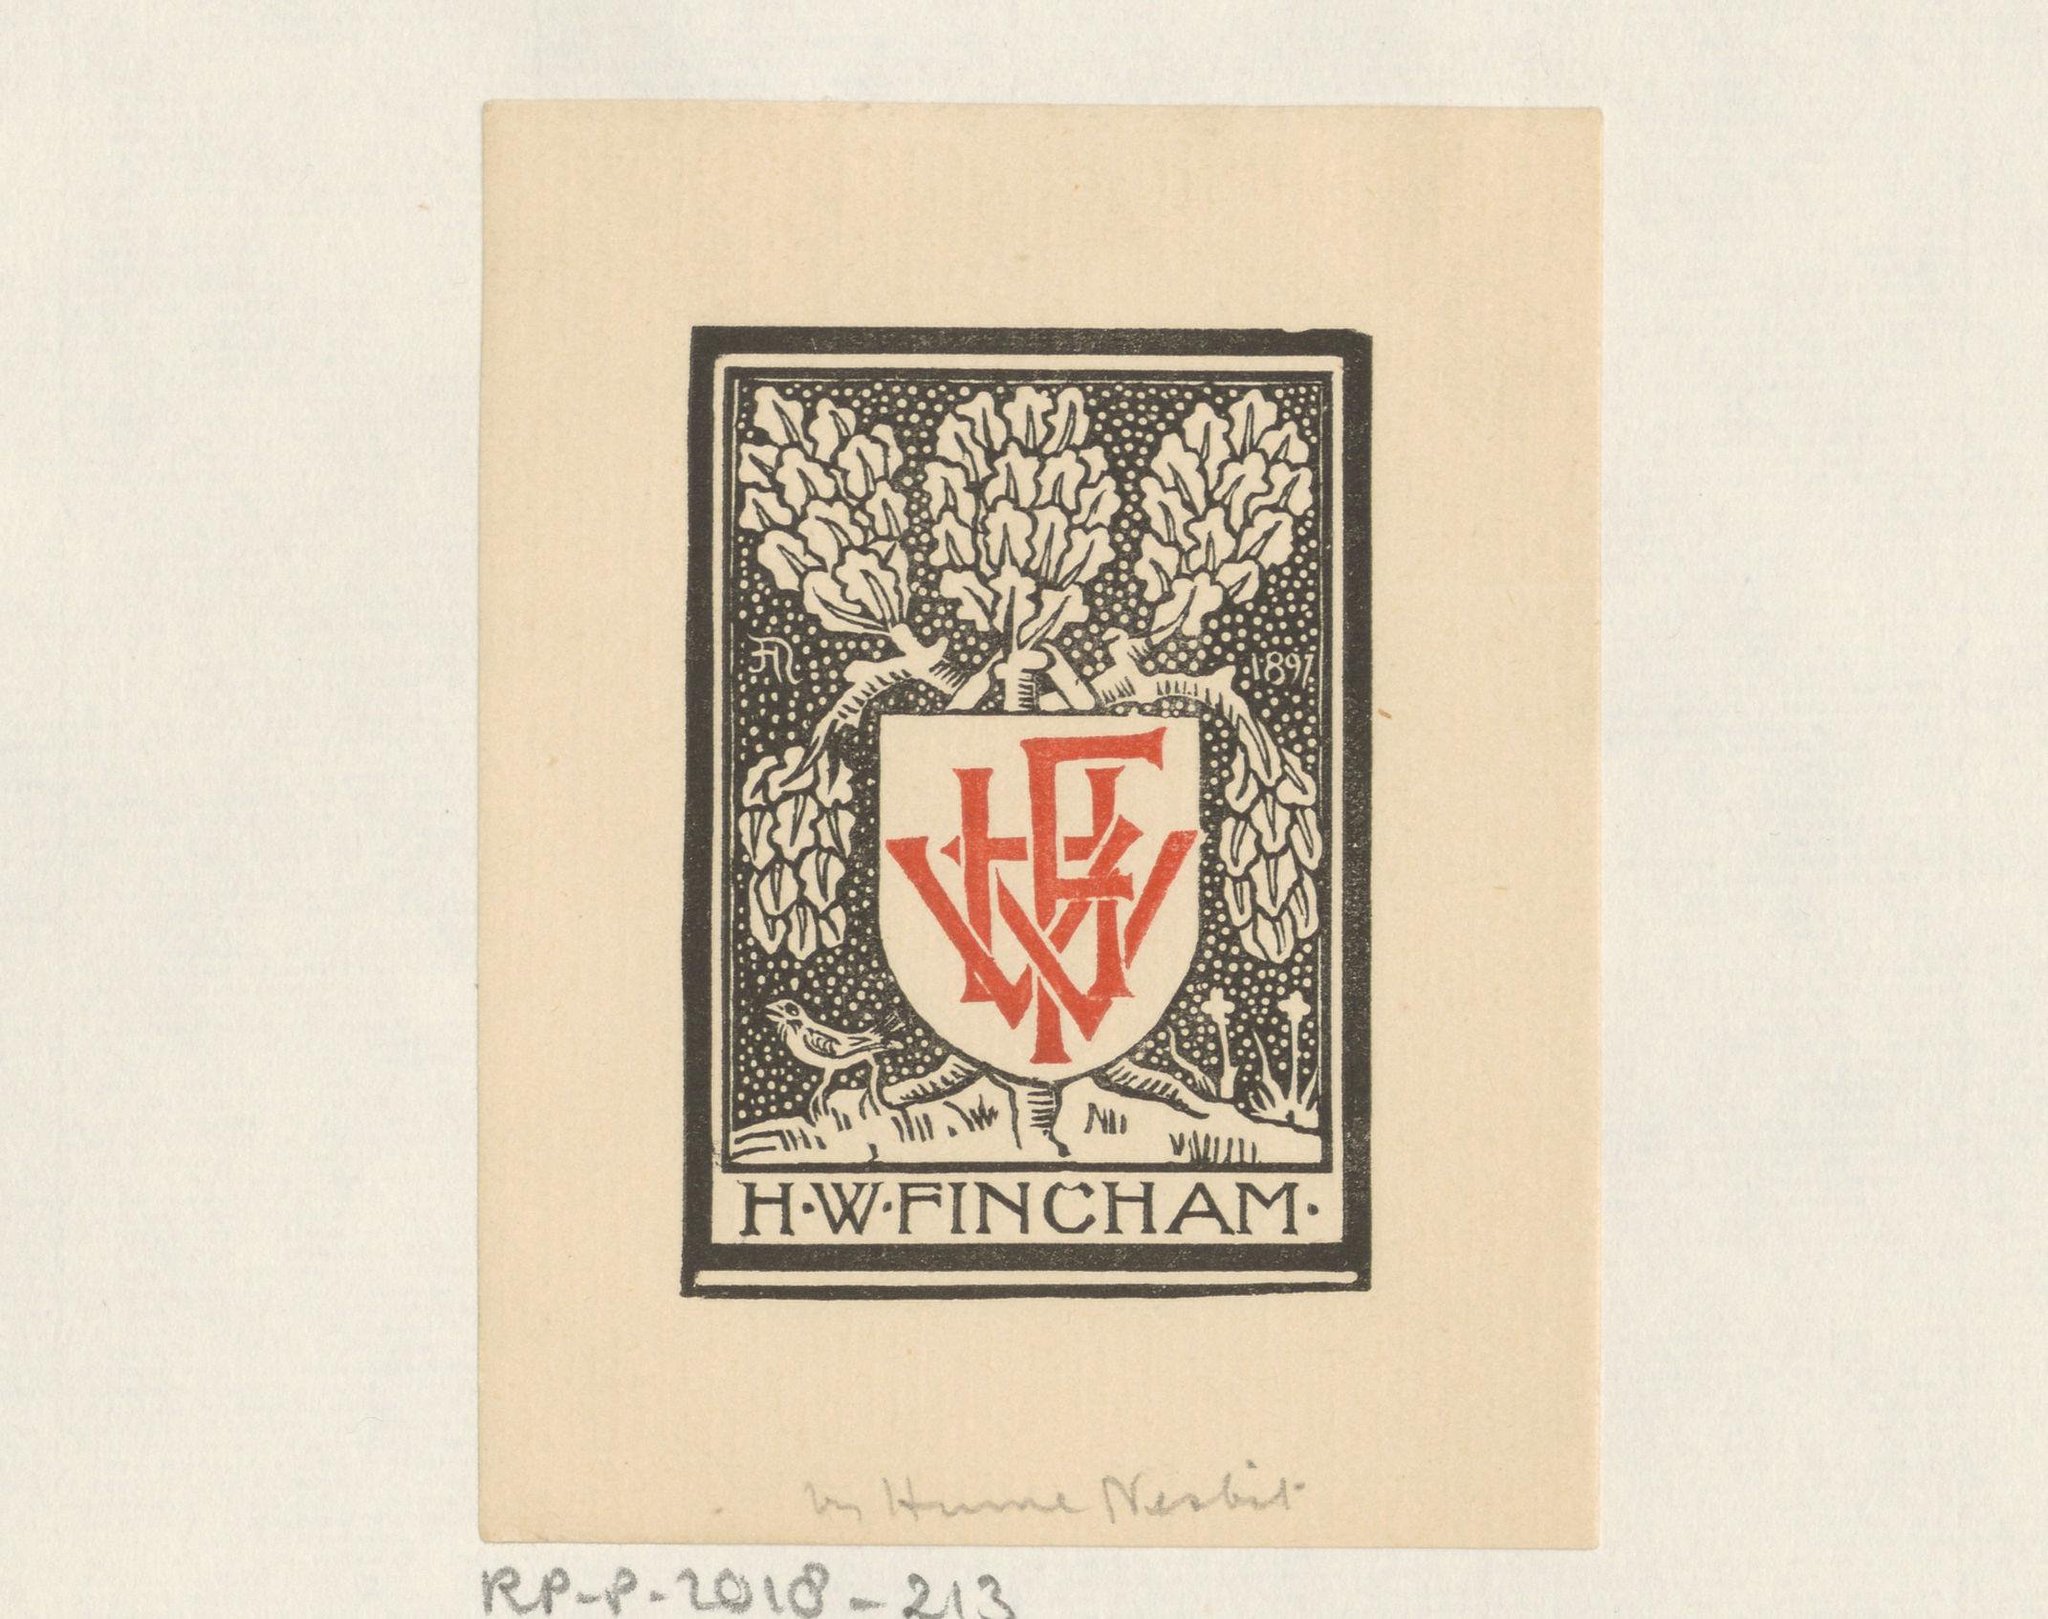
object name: bookplate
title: Ex libris van Henry Walter Fincham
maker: Anonymous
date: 1870-1952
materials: paper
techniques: woodcut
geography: england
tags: birds, plants and herbs, armorial bearing, heraldry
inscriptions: inscription: ‘by H[...] Nesbit [?]’